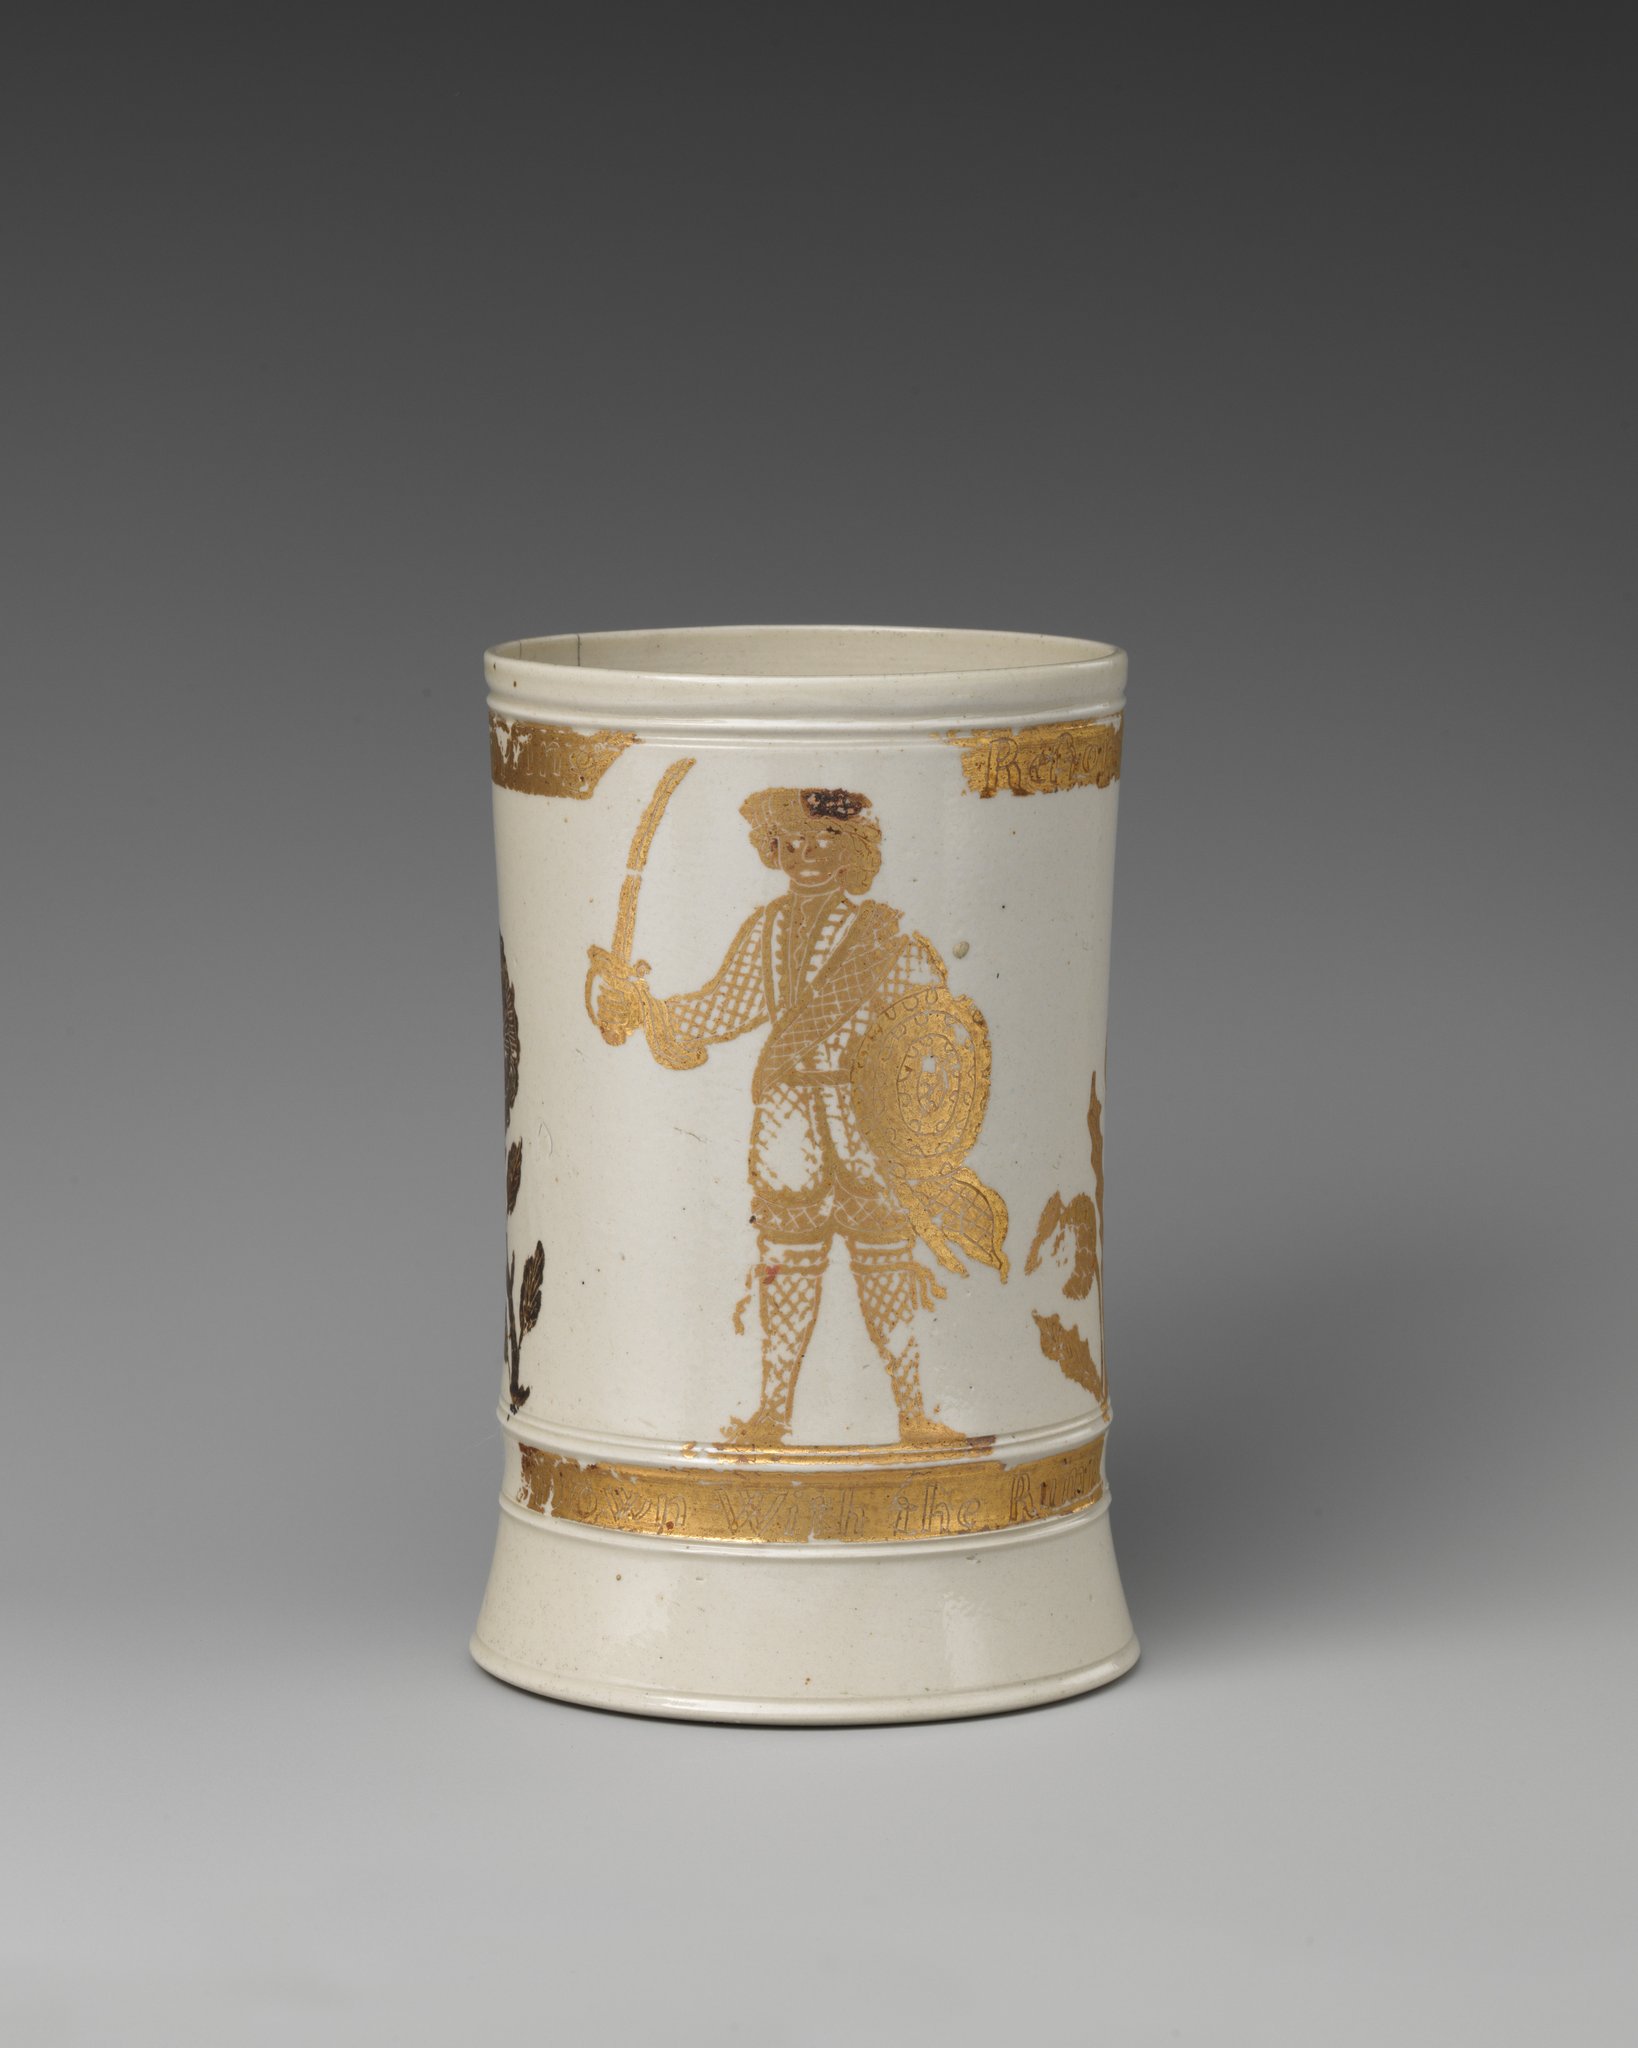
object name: mug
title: Jacobite mug with Prince Charles Edward Stuart (1720–1788)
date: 1745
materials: gilt, stoneware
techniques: salt glaze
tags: shields,swords,men